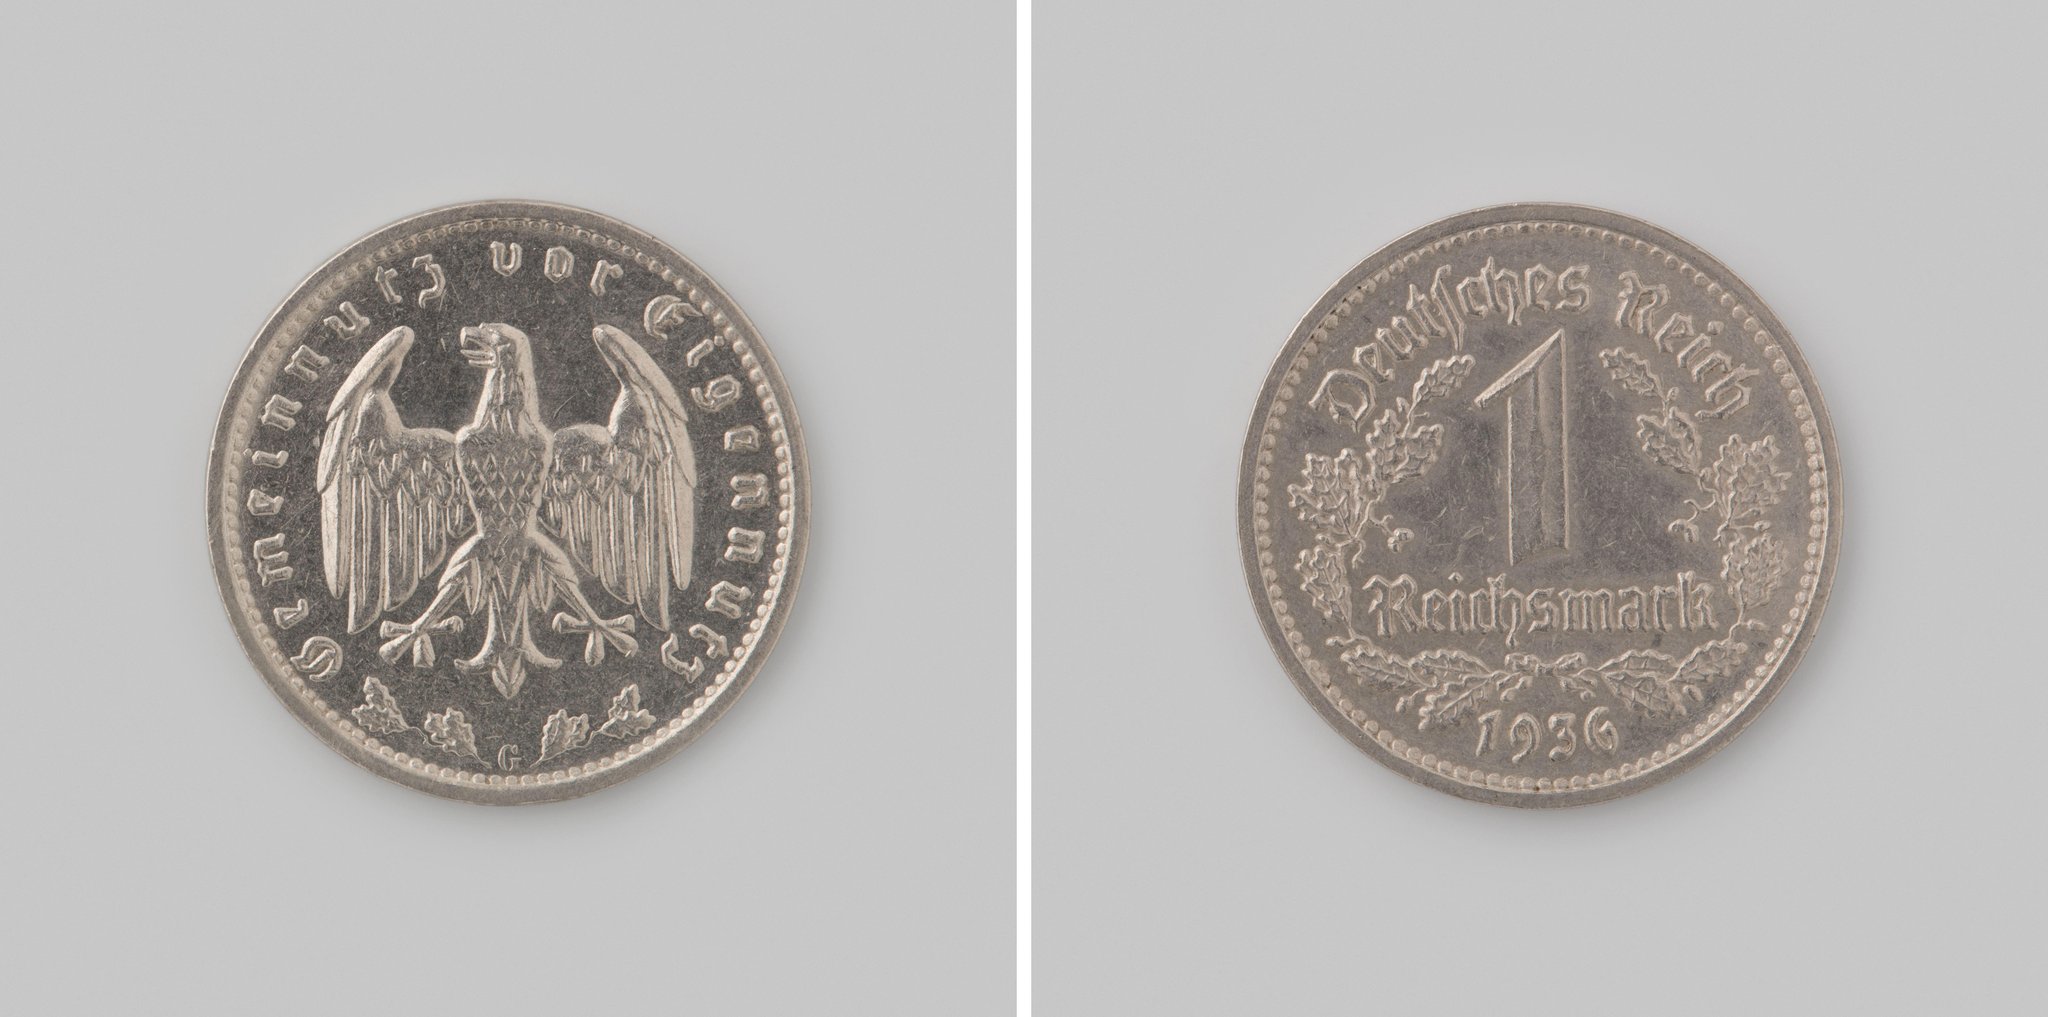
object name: reichsmark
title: Reichsmark uit Duitsland, Derde Rijk, 1936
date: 1936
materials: nickel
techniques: striking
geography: karlsruhe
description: Nikkelen munt. Voorzijde: enkelkoppige adelaar naar links. Letter G onderaan. Keerzijde: binnen twee samengebonden eiketakken waarde-aanduiding in twee regels. Jaartal onderaan. Randversiering.